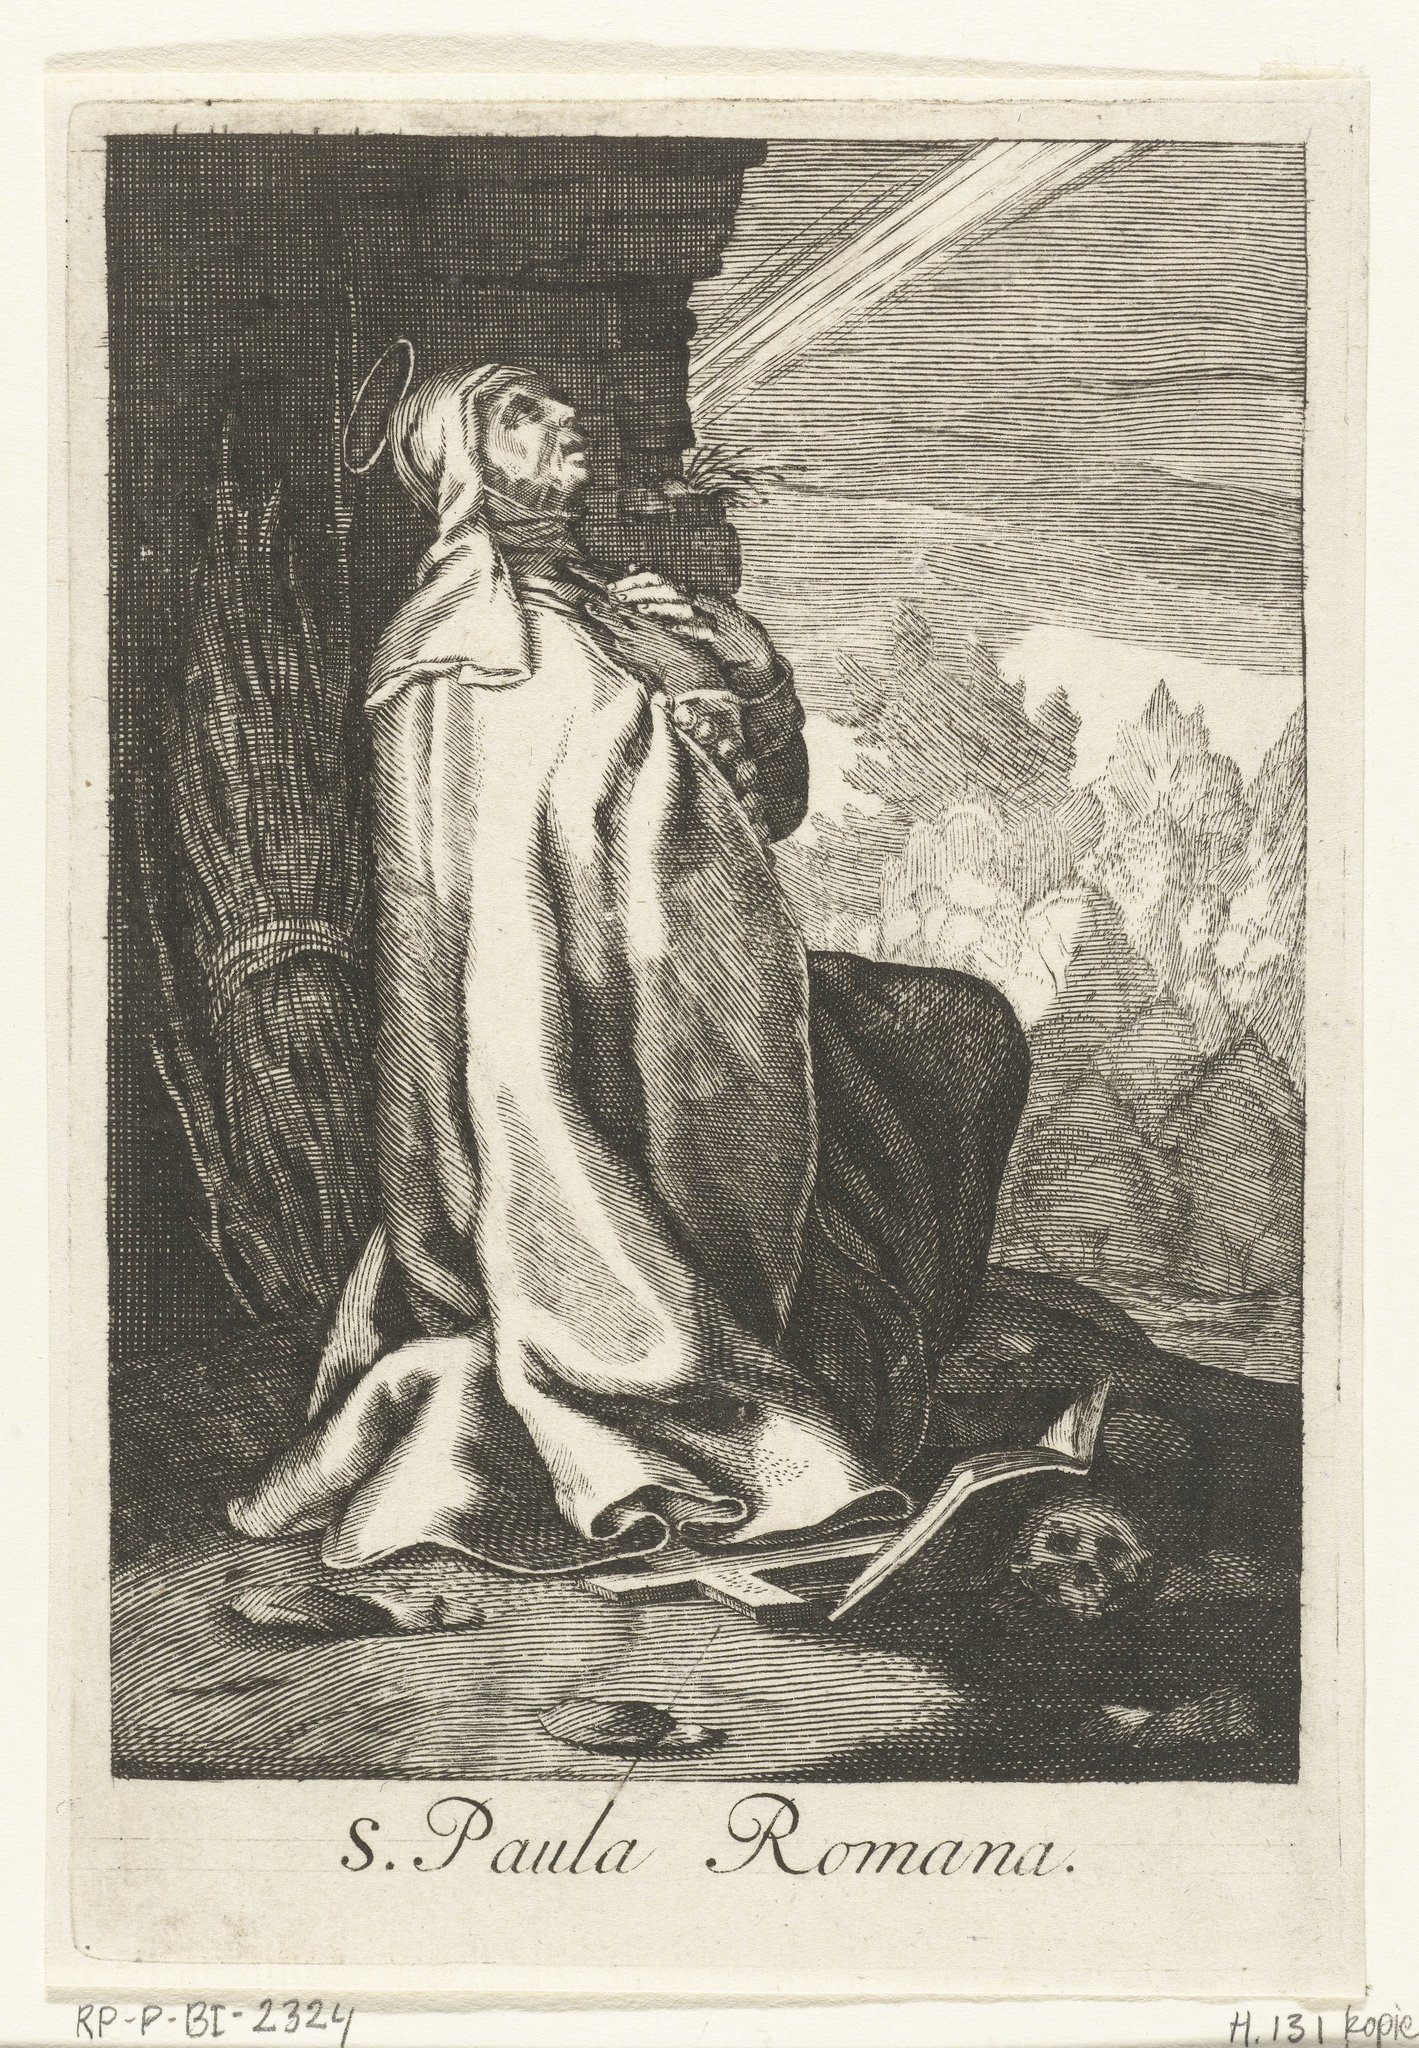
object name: print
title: Sacra Eremus Ascetriarum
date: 1590-1662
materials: paper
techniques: engraving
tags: anchorite, hermit, female saints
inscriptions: collector's mark: Lugt 2228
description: Kopie in spiegelbeeld naar prent van Boëtius Adamsz. Bolswert uit serie Kluizenaressen.